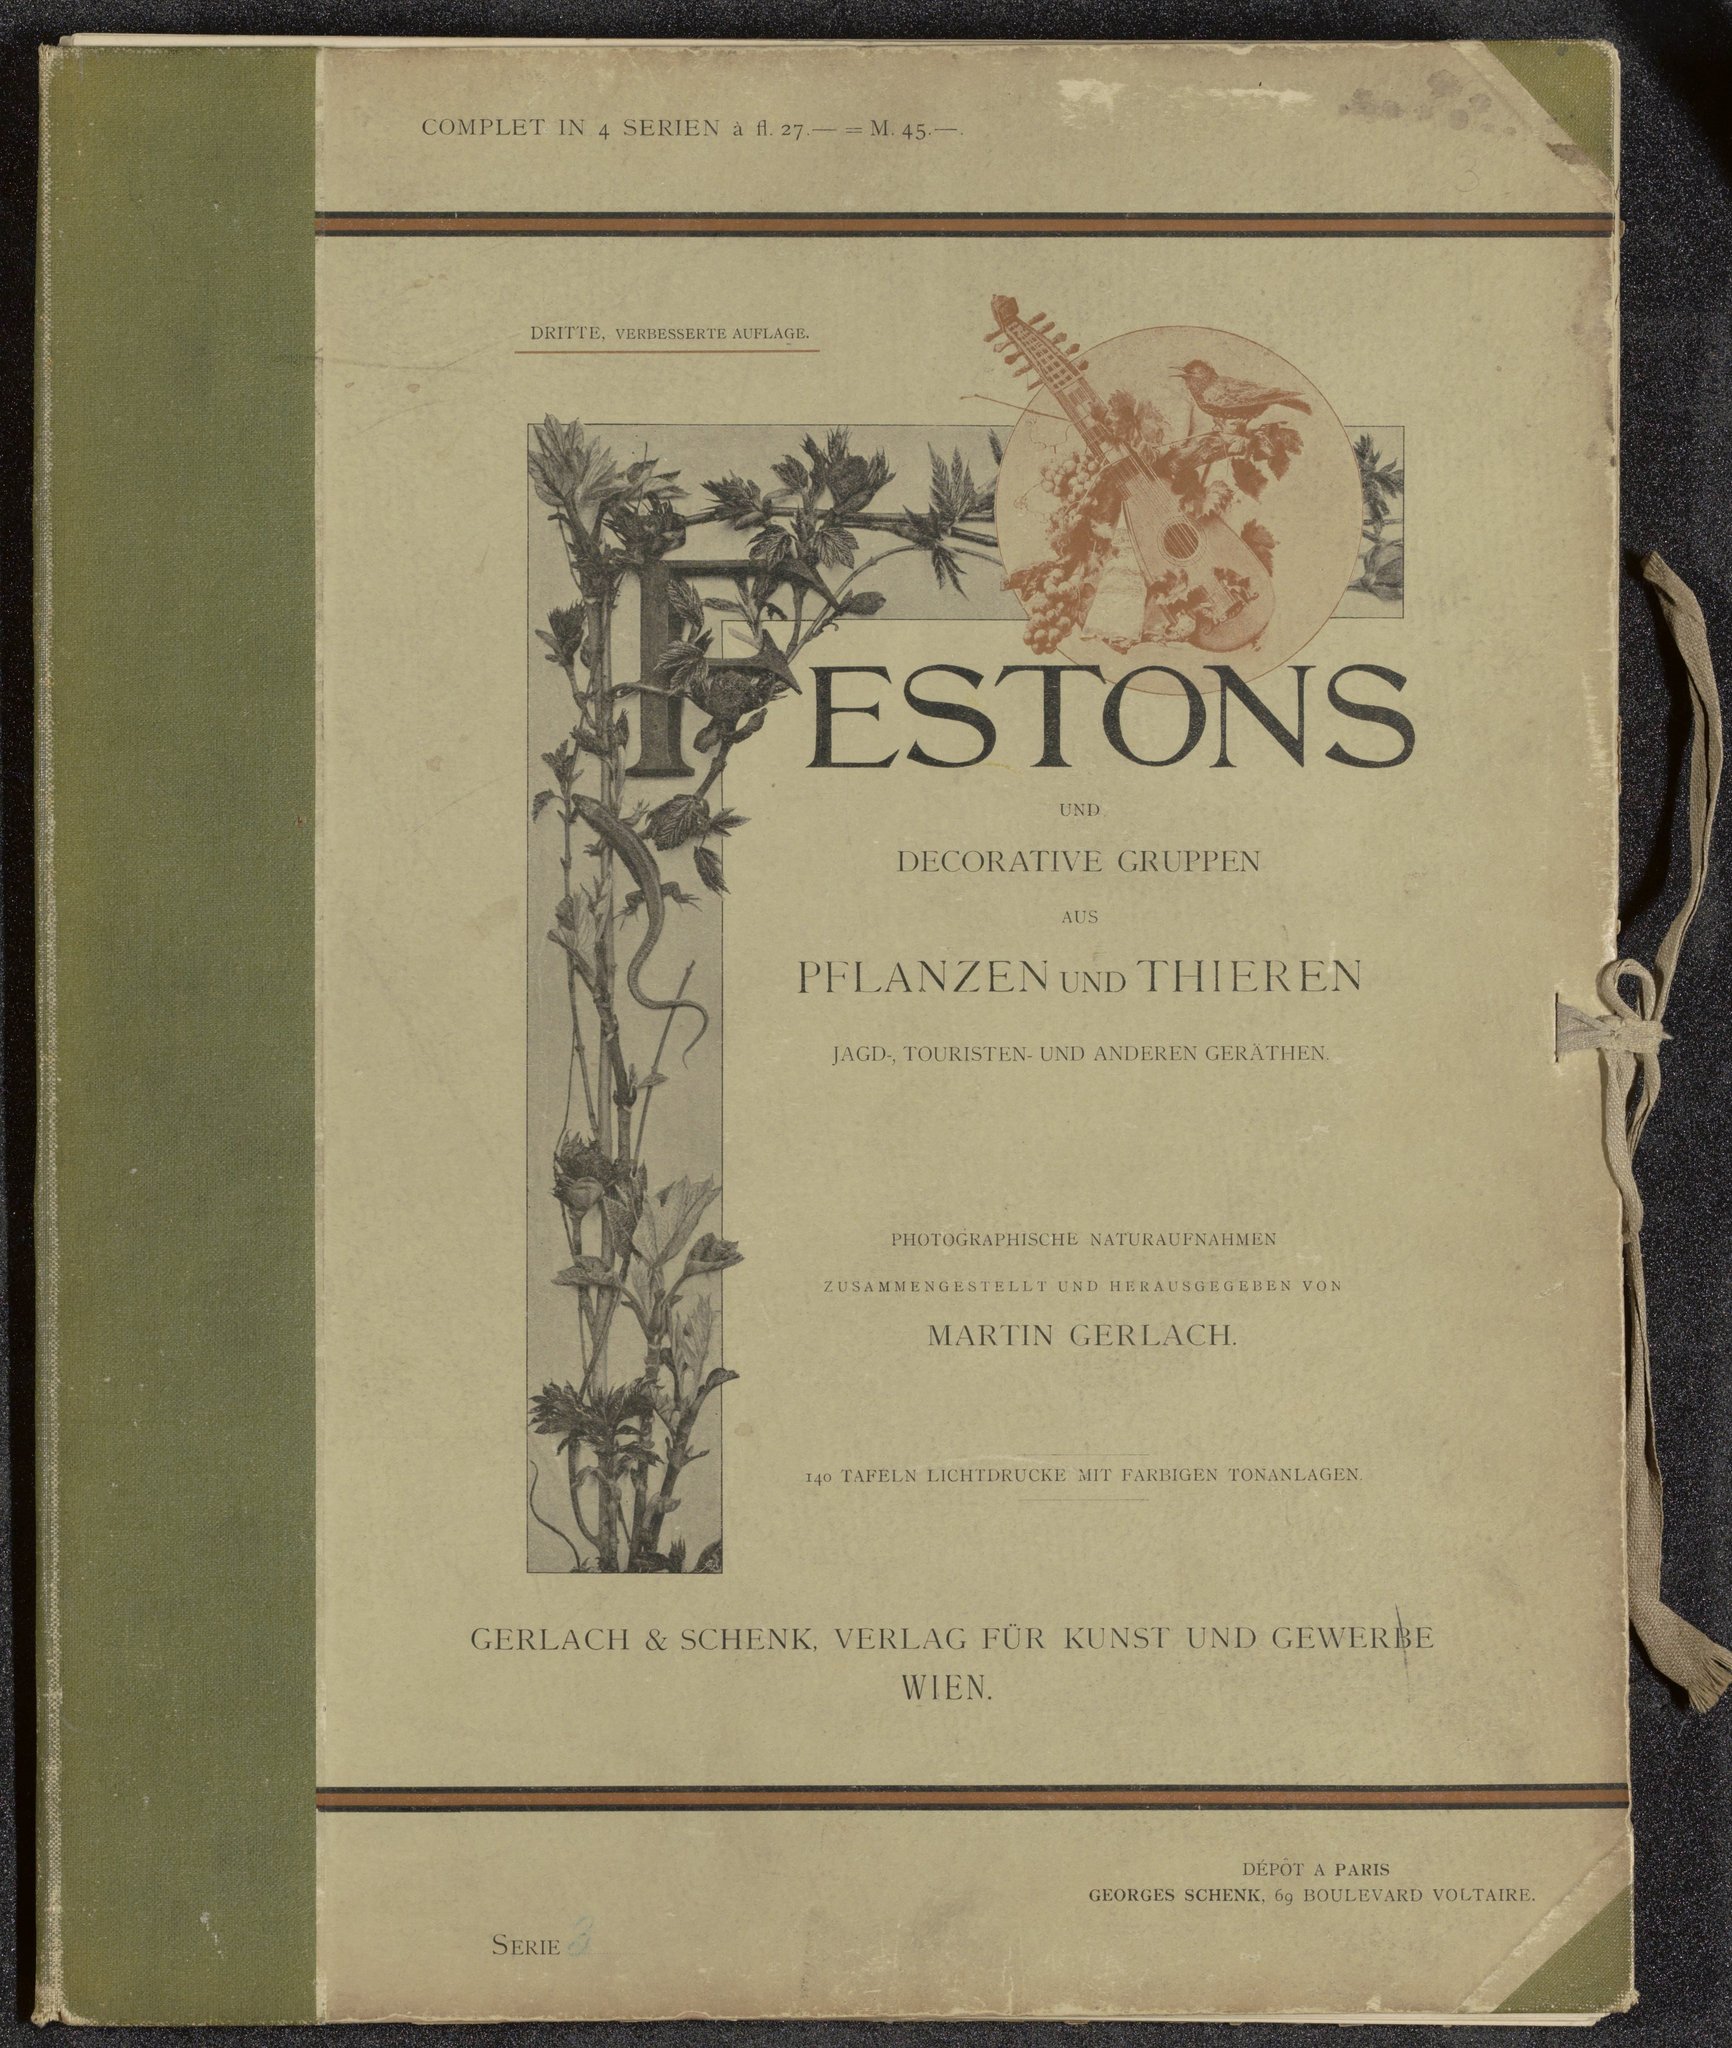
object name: portfolio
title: Festons und decorative Gruppen nebst einem Zieralphabete aus Pflanzen und Thieren Jagd-, Touristen- und anderen Geräthen serie 3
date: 1897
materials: cardboard, linen, paper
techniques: photograph, printing